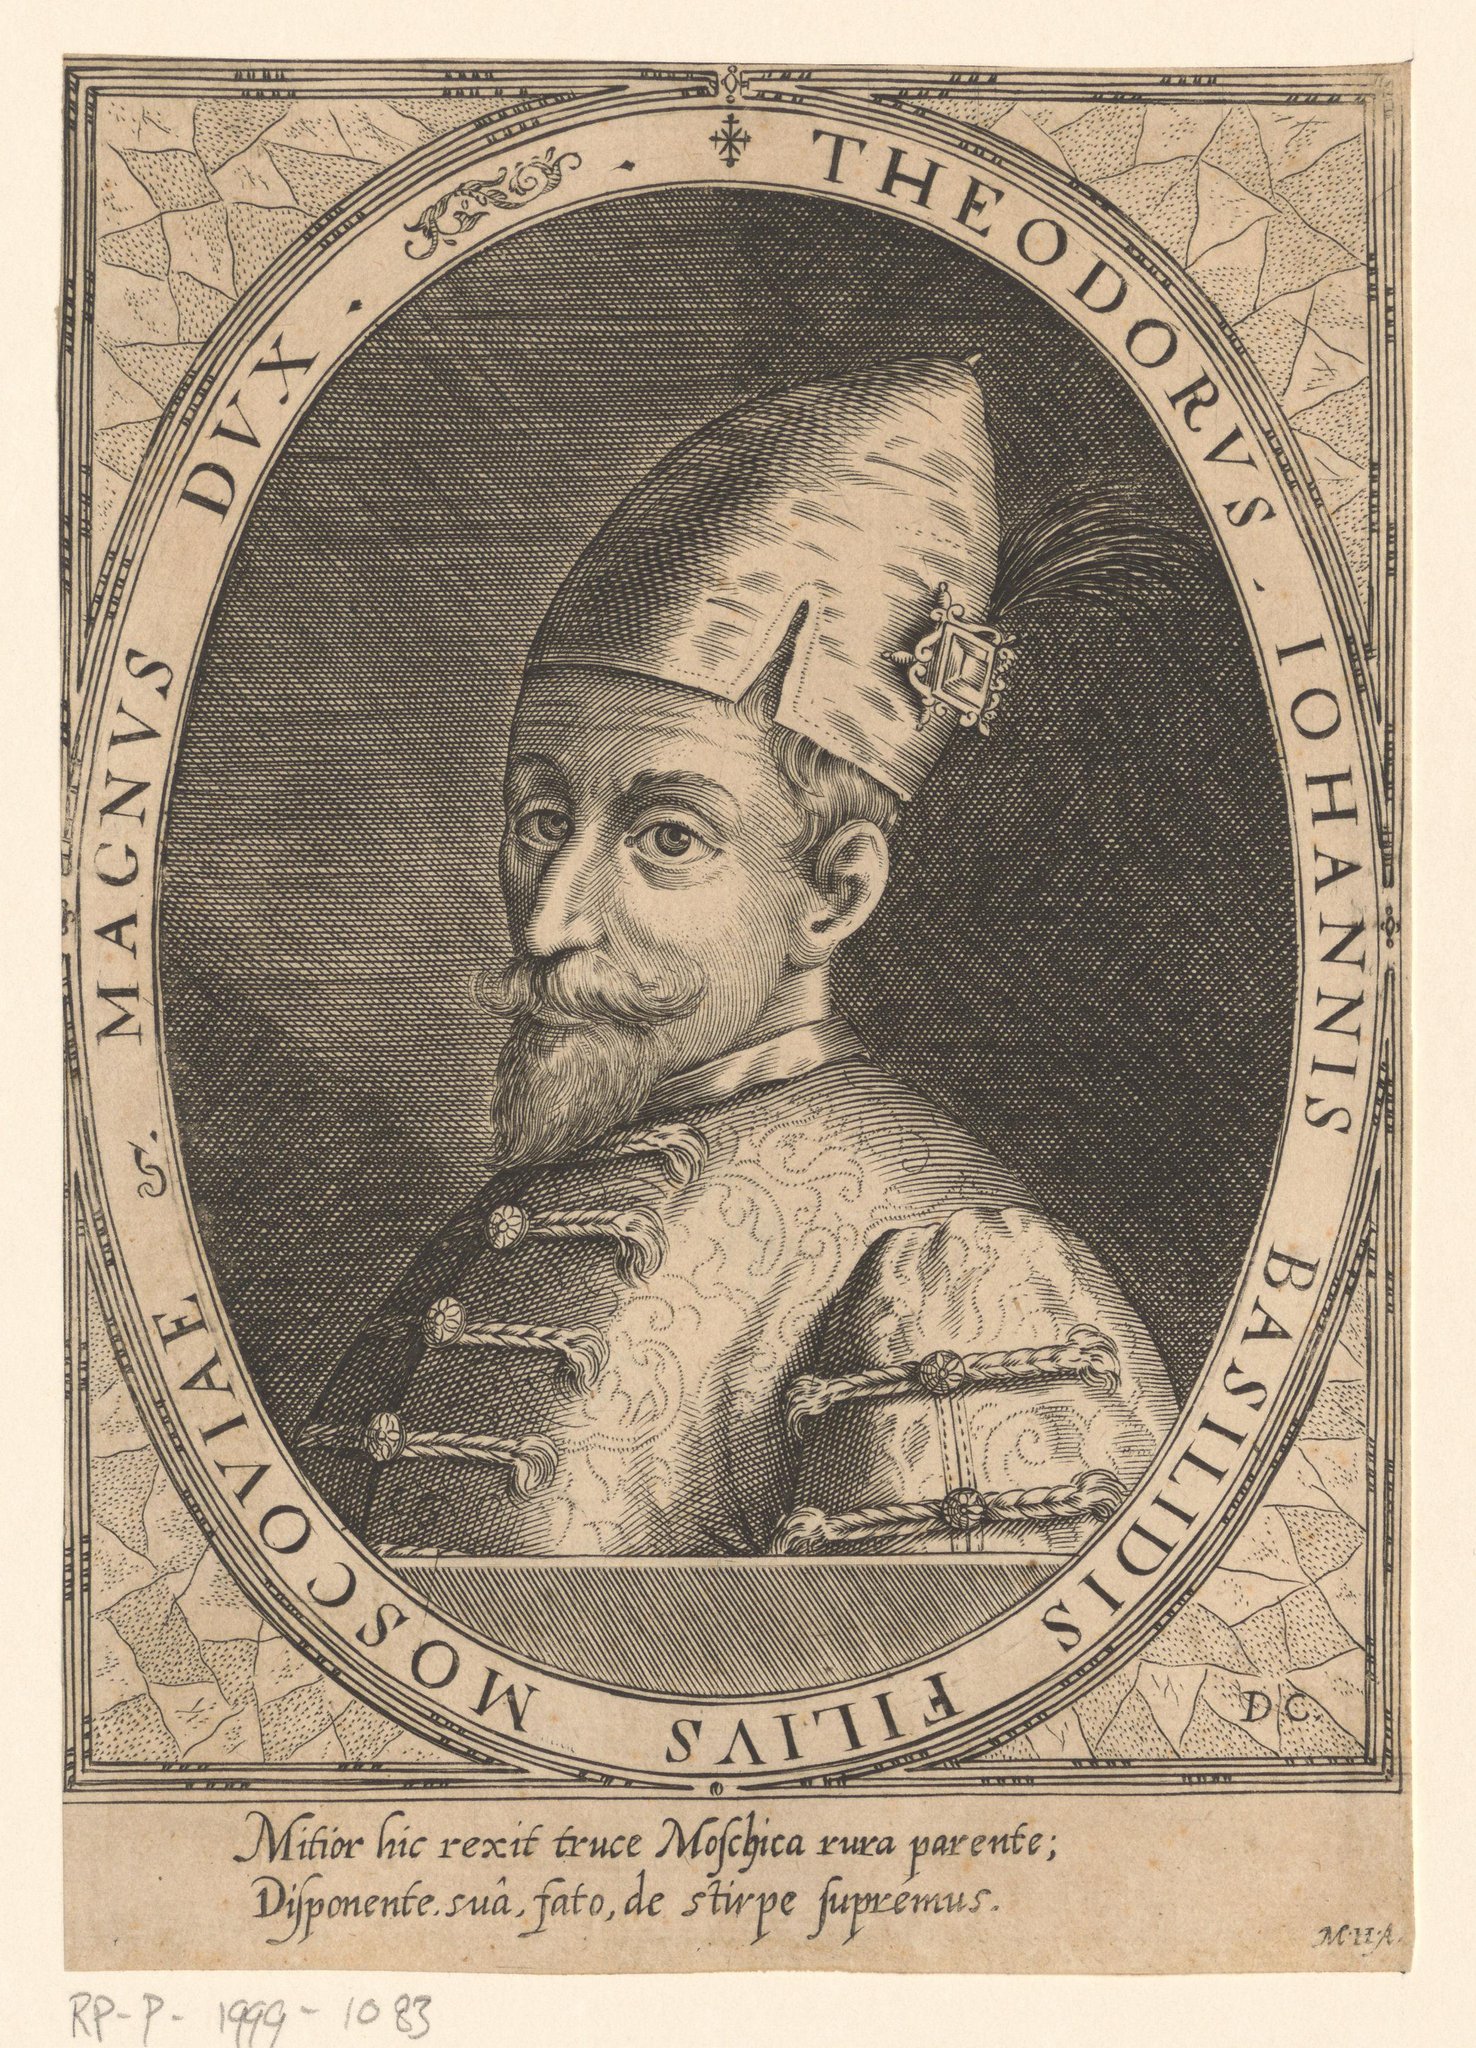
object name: print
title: Portretten van bekende personen uit de zestiende eeuw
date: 1600-1604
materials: paper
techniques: engraving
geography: augsburg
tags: historical persons, emperor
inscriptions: monogram: ‘DC.’, collector's mark: Lugt 2228, monogram: ‘M.H.A.’, collector's mark: Lugt 2760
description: De serie werd tussen 1600 en 1604 in vier delen uitgegeven. De graveurs waren Custos en Kilian.